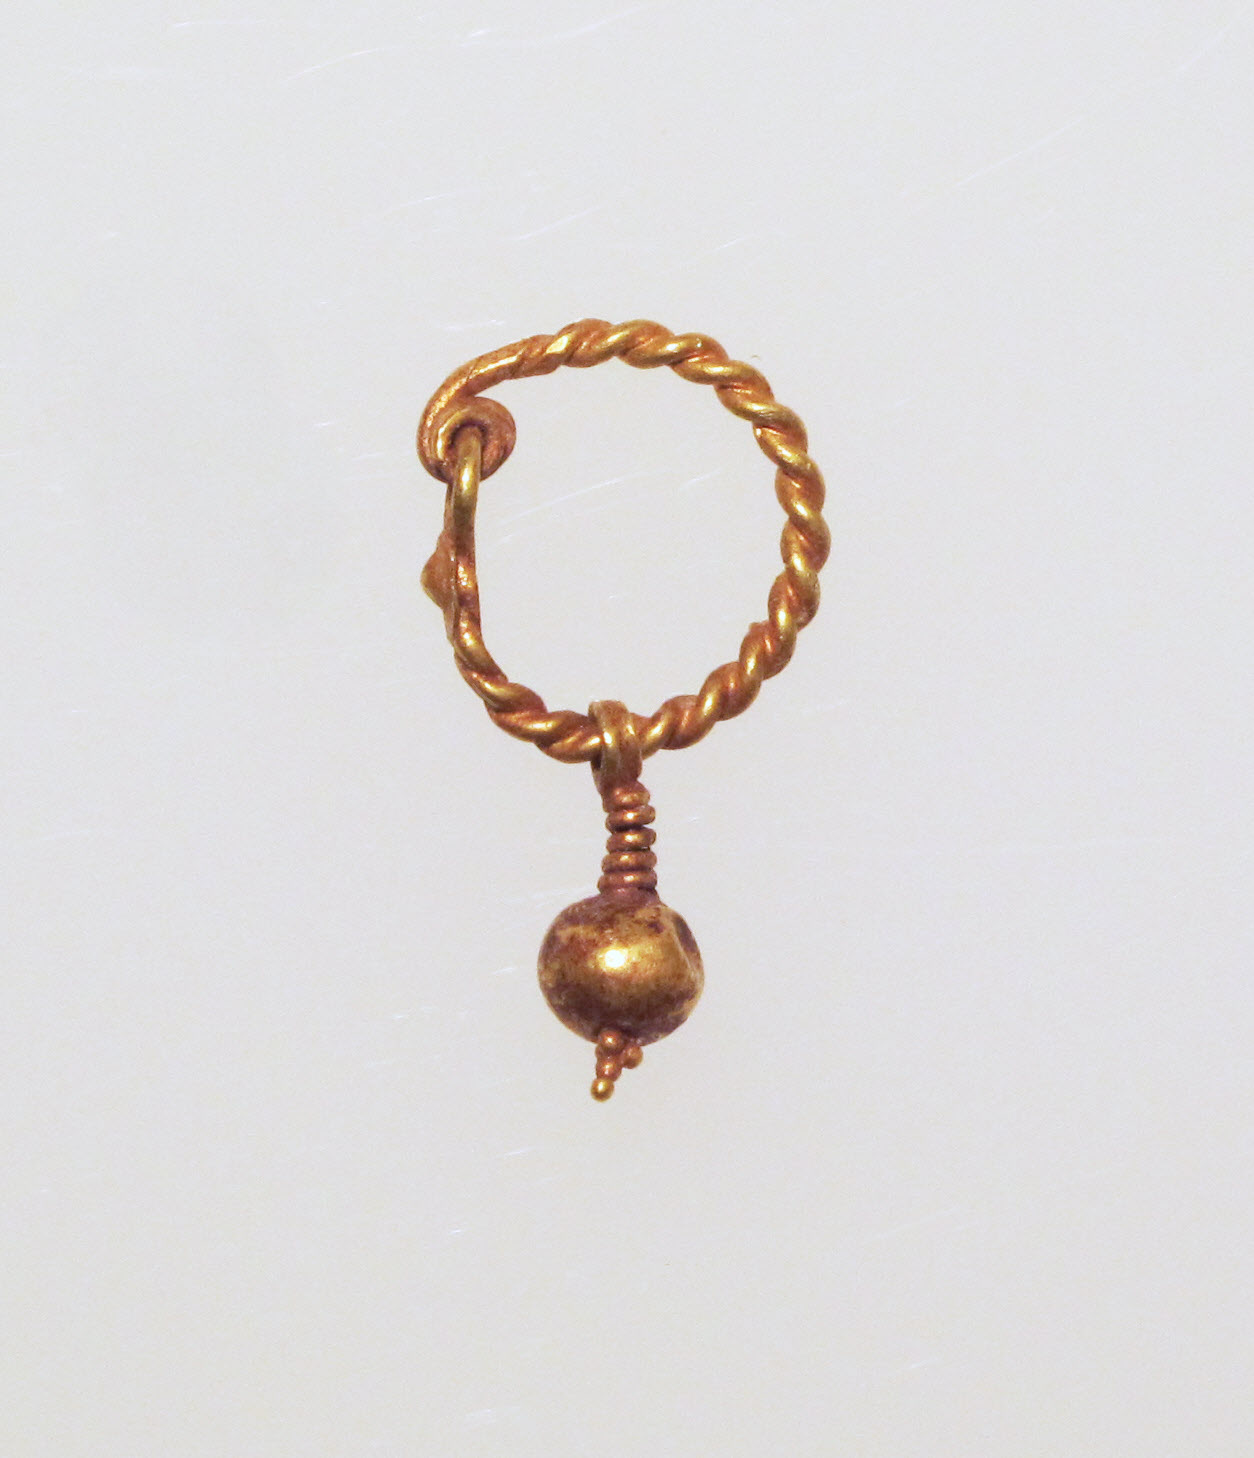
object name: earring with ball pendant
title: Gold earring with pendant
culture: roman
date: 101-200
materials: gold